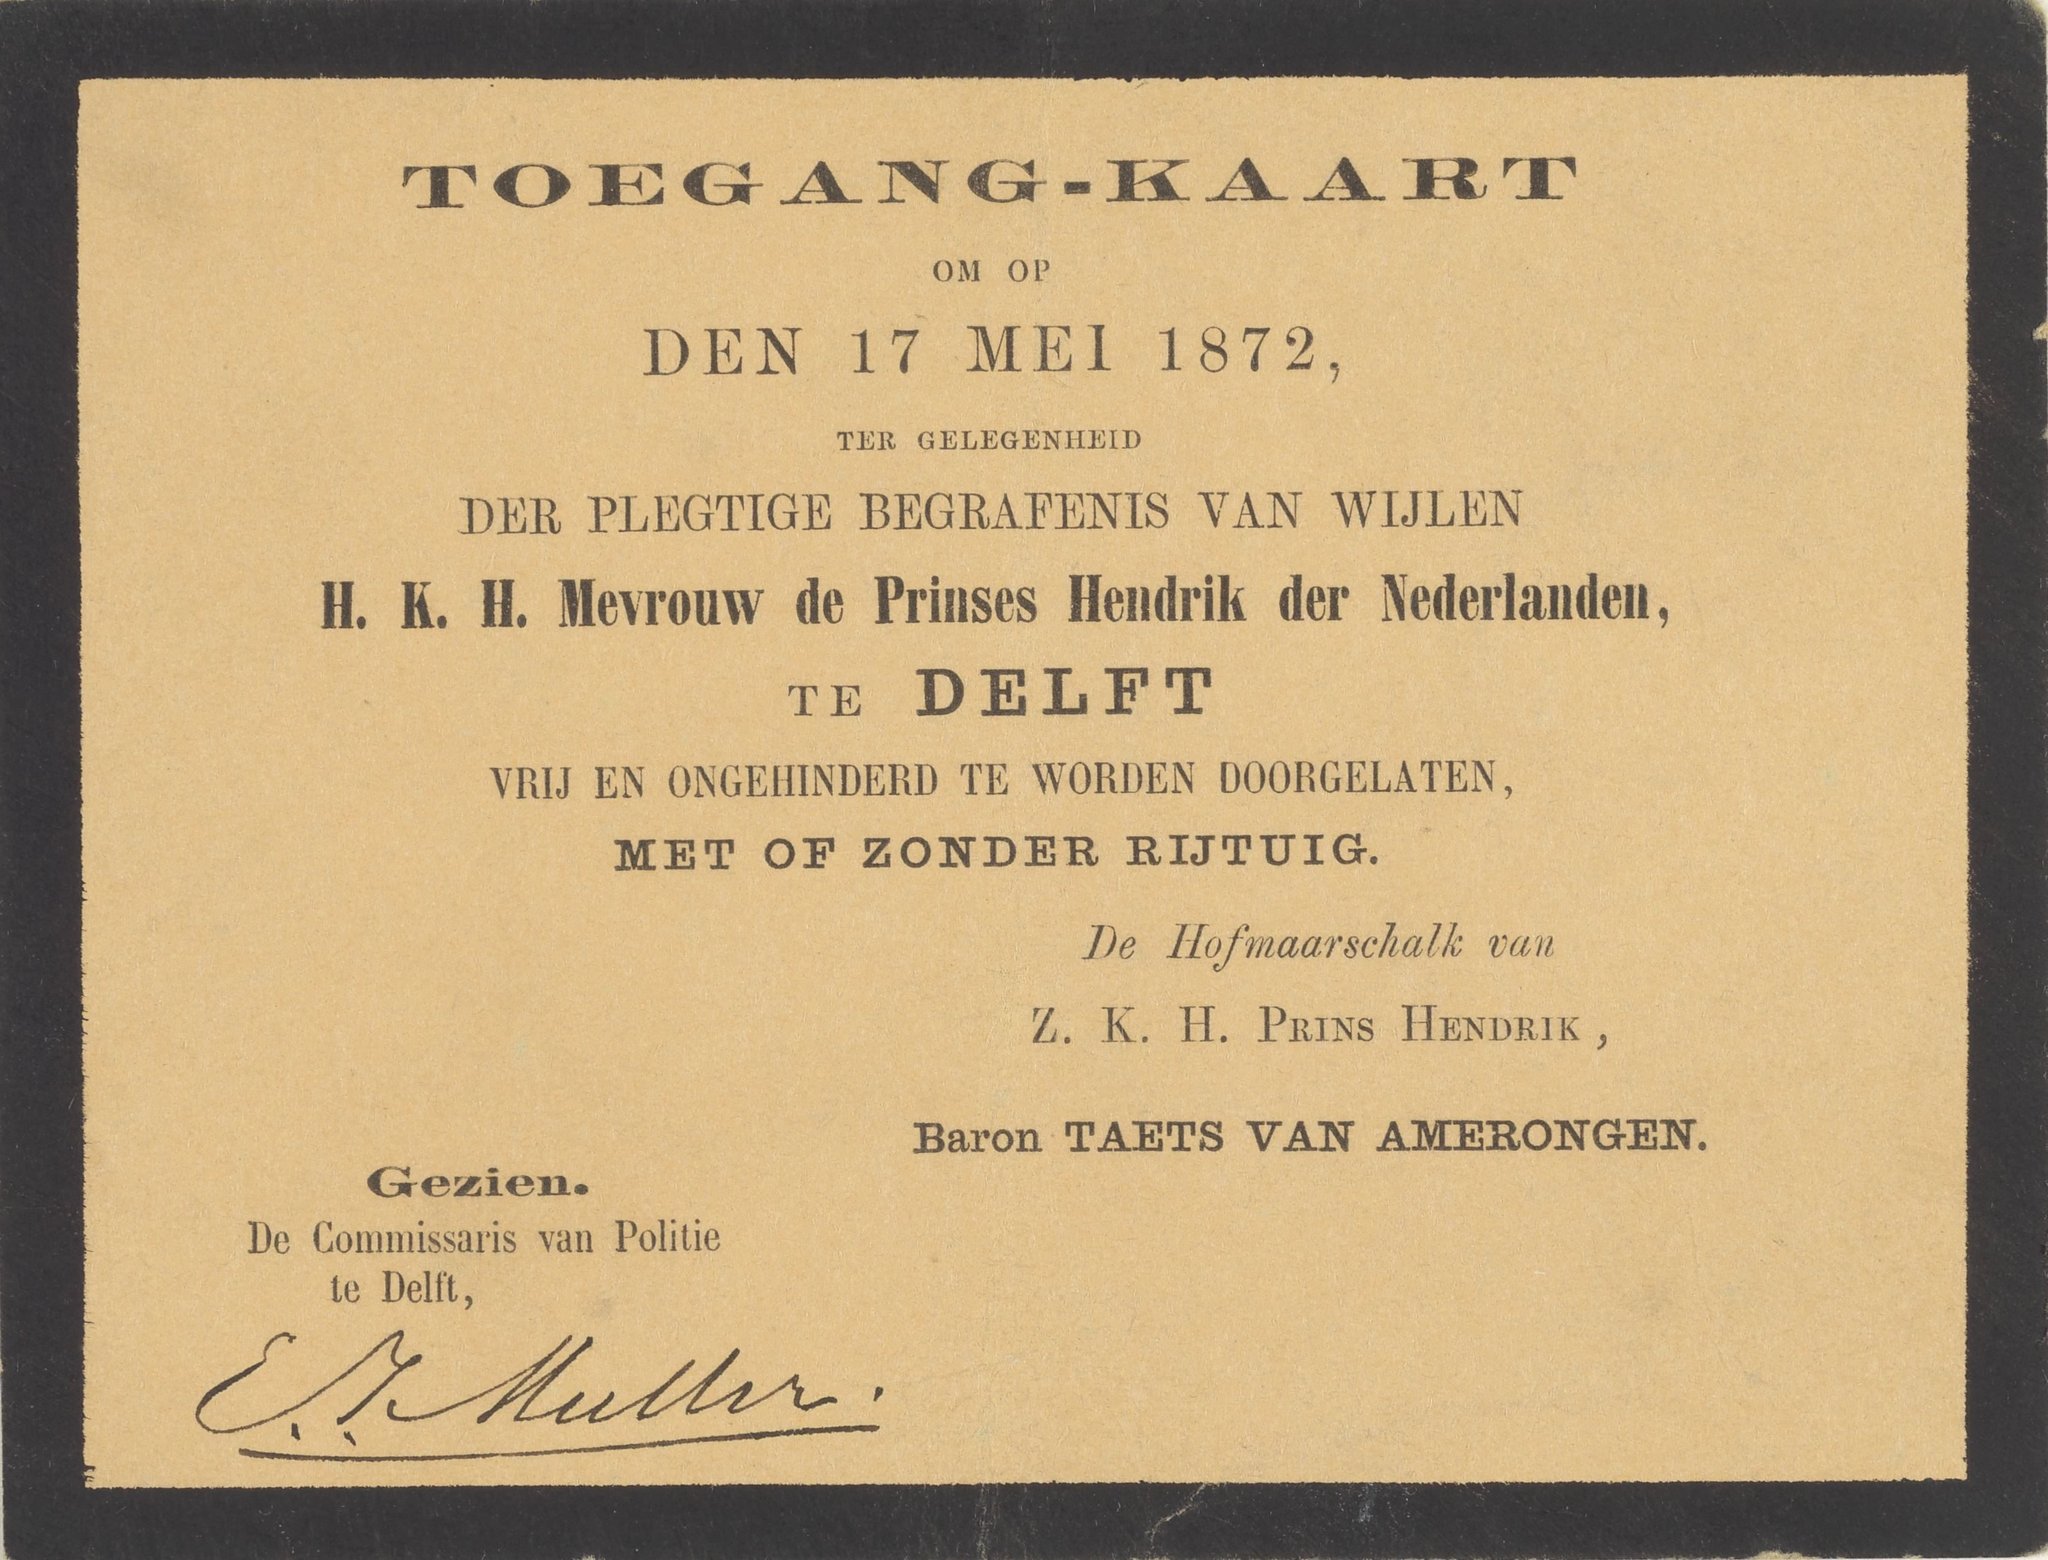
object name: admission ticket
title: Toegangskaart voor de begrafenis van prinses Amalia van Saksen-Weimar-Eisenach, 1872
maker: Anonymous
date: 1872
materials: paper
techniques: letterpress printing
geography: netherlands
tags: delft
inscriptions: collector's mark: Lugt 2228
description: Toegangskaart voor de begrafenis van prinses Amalia van Saksen-Weimar-Eisenach, echtgenote van prins Hendrik, op 17 mei 1872, te Delft. Kaartje met zwarte rouwranden.